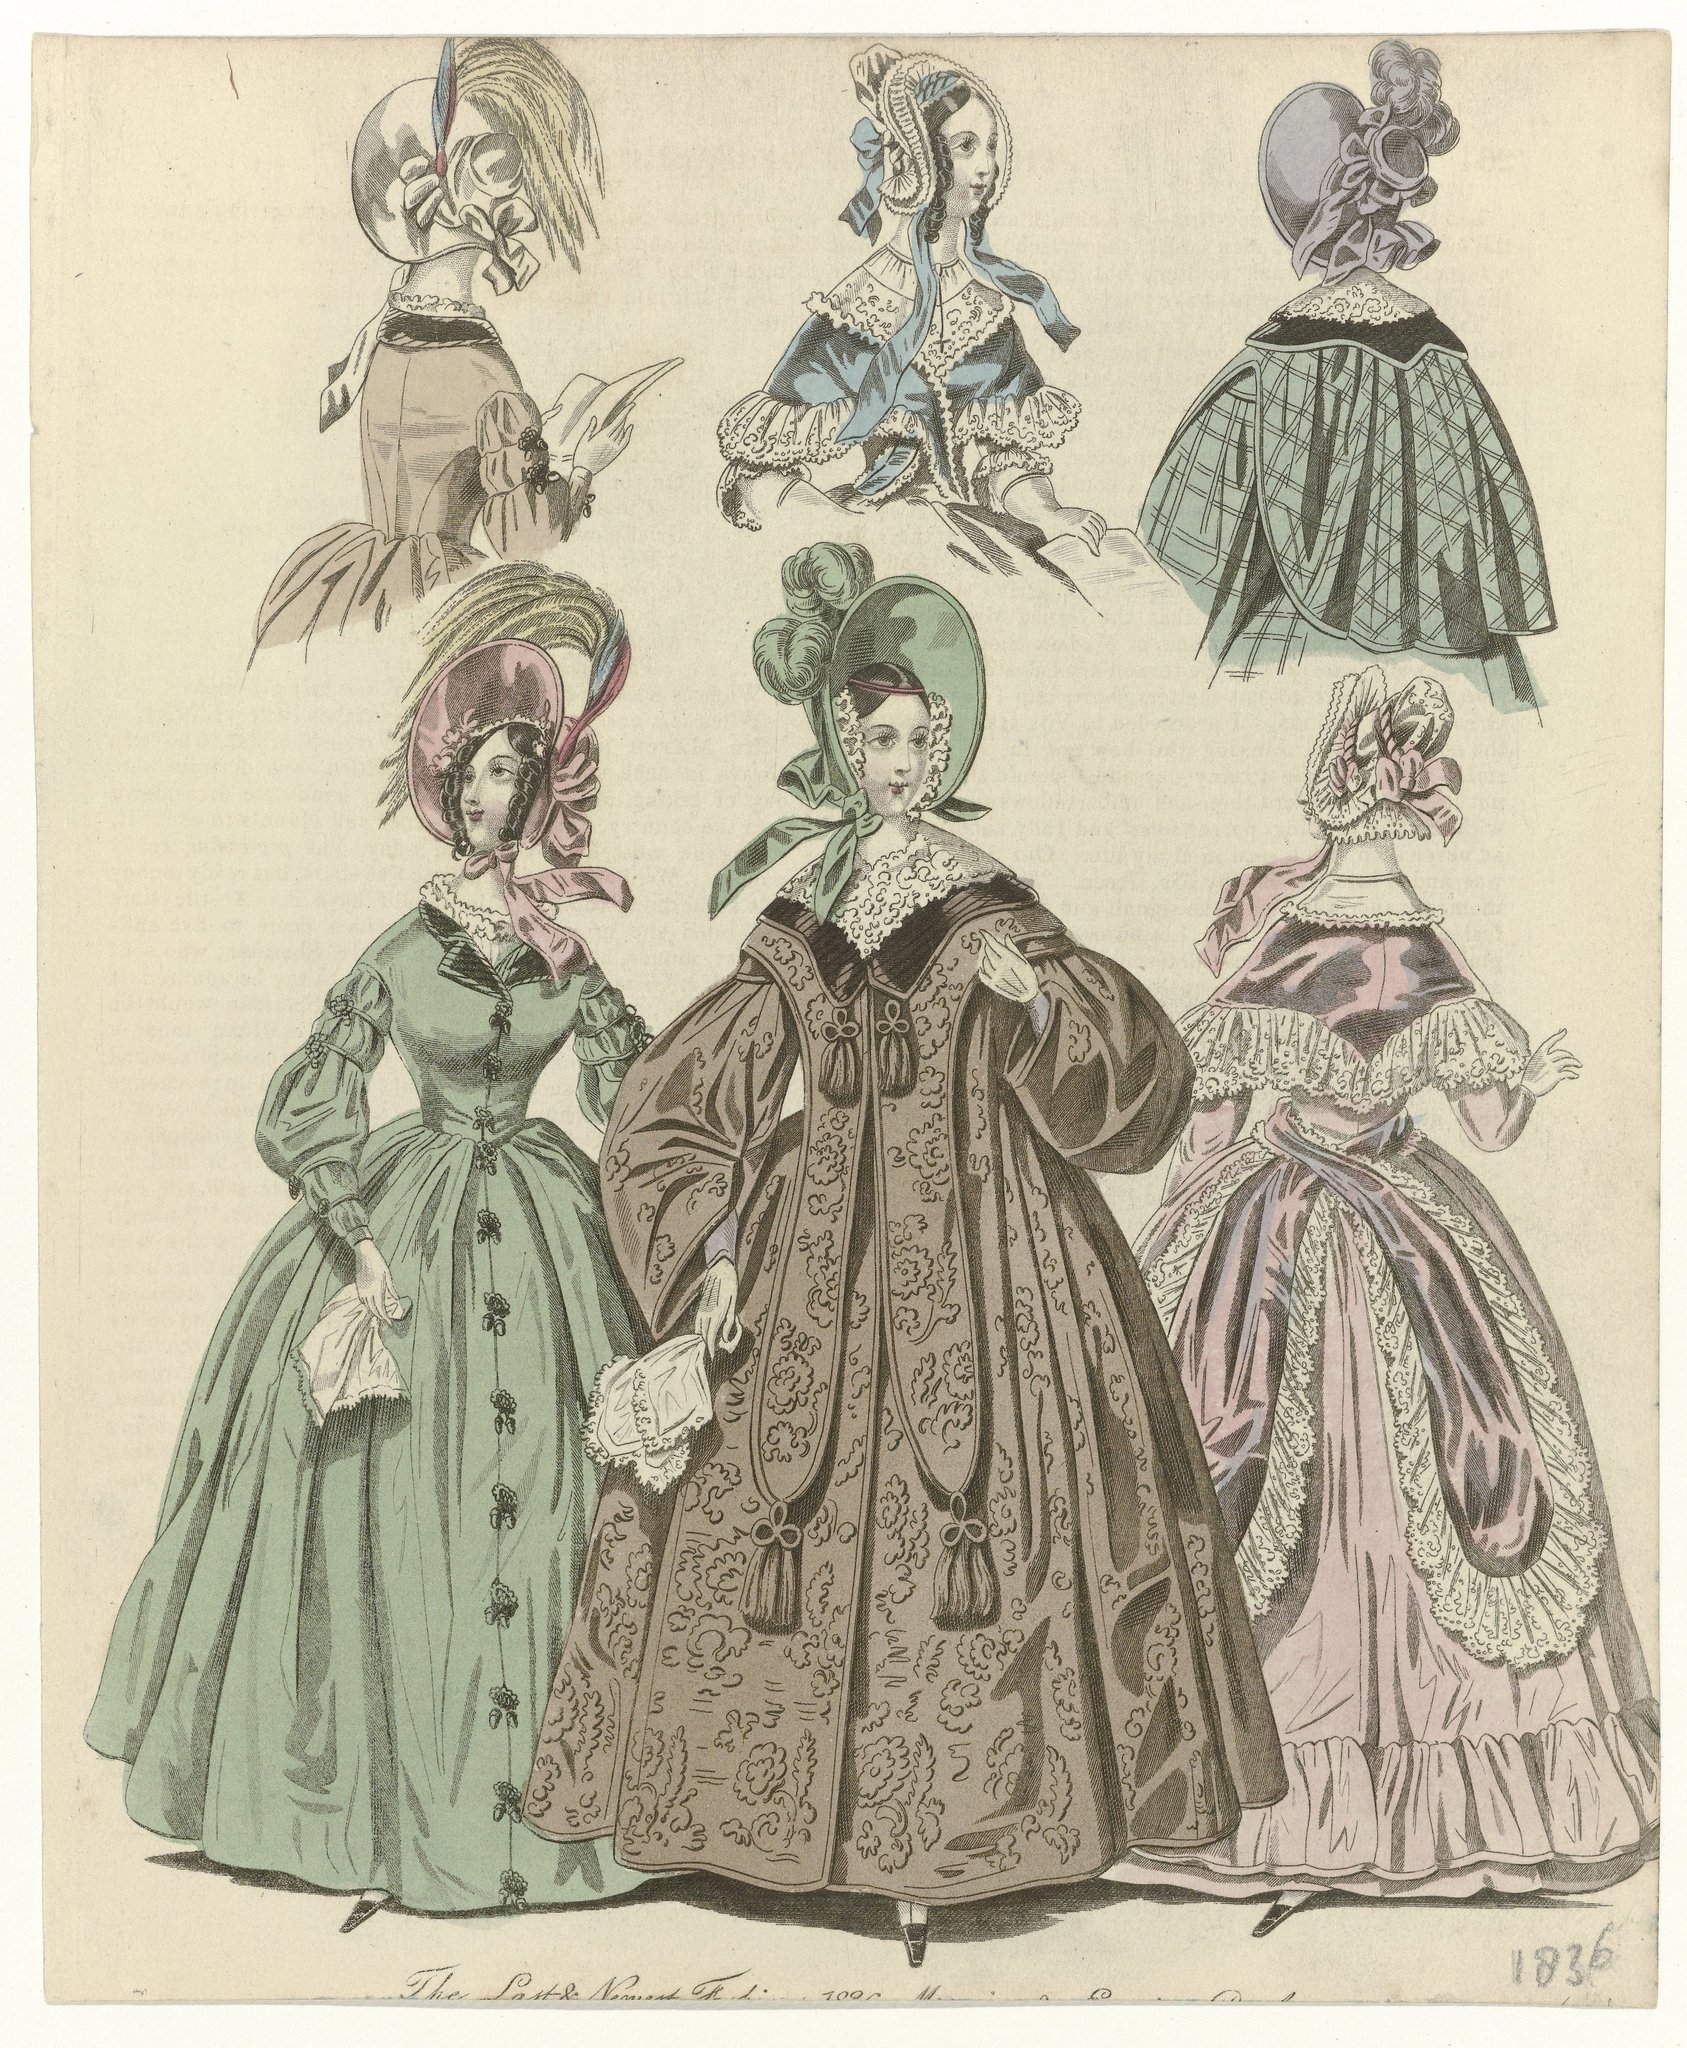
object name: fashion print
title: The World of Fashion, 1836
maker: Anonymous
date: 1836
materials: paper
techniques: etching, hand coloring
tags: handkerchief (+ women's clothes), gloves, mittens (long gloves) (+ women's clothes), coat (+ women's clothes), head-gear: cap (+ women's clothes), fashion plates, shoes, sandals (+ women's clothes), dress, gown (+ women's clothes), neck-gear ~ clothing (+ women's clothes)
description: De laatste en nieuwste modes uit 1836. Japon met lange geplooide mouwen. Mantel met bloem-en bladmotief. Wijd uitlopende mouwen. Bijpassende schoudermantel(?) met slippen, uitlopend in kwasten. Japon met kleine schoudermantel, afgezet met geplooide strook stof. Slippen naar achteren gedrapeerd. Accessoires: luifelhoed met veren, muts met lint, handschoenen, zakdoek, schoenen met vierkante neuzen. Prent uit het modetijdschrift The World of Fashion (1824-1891).